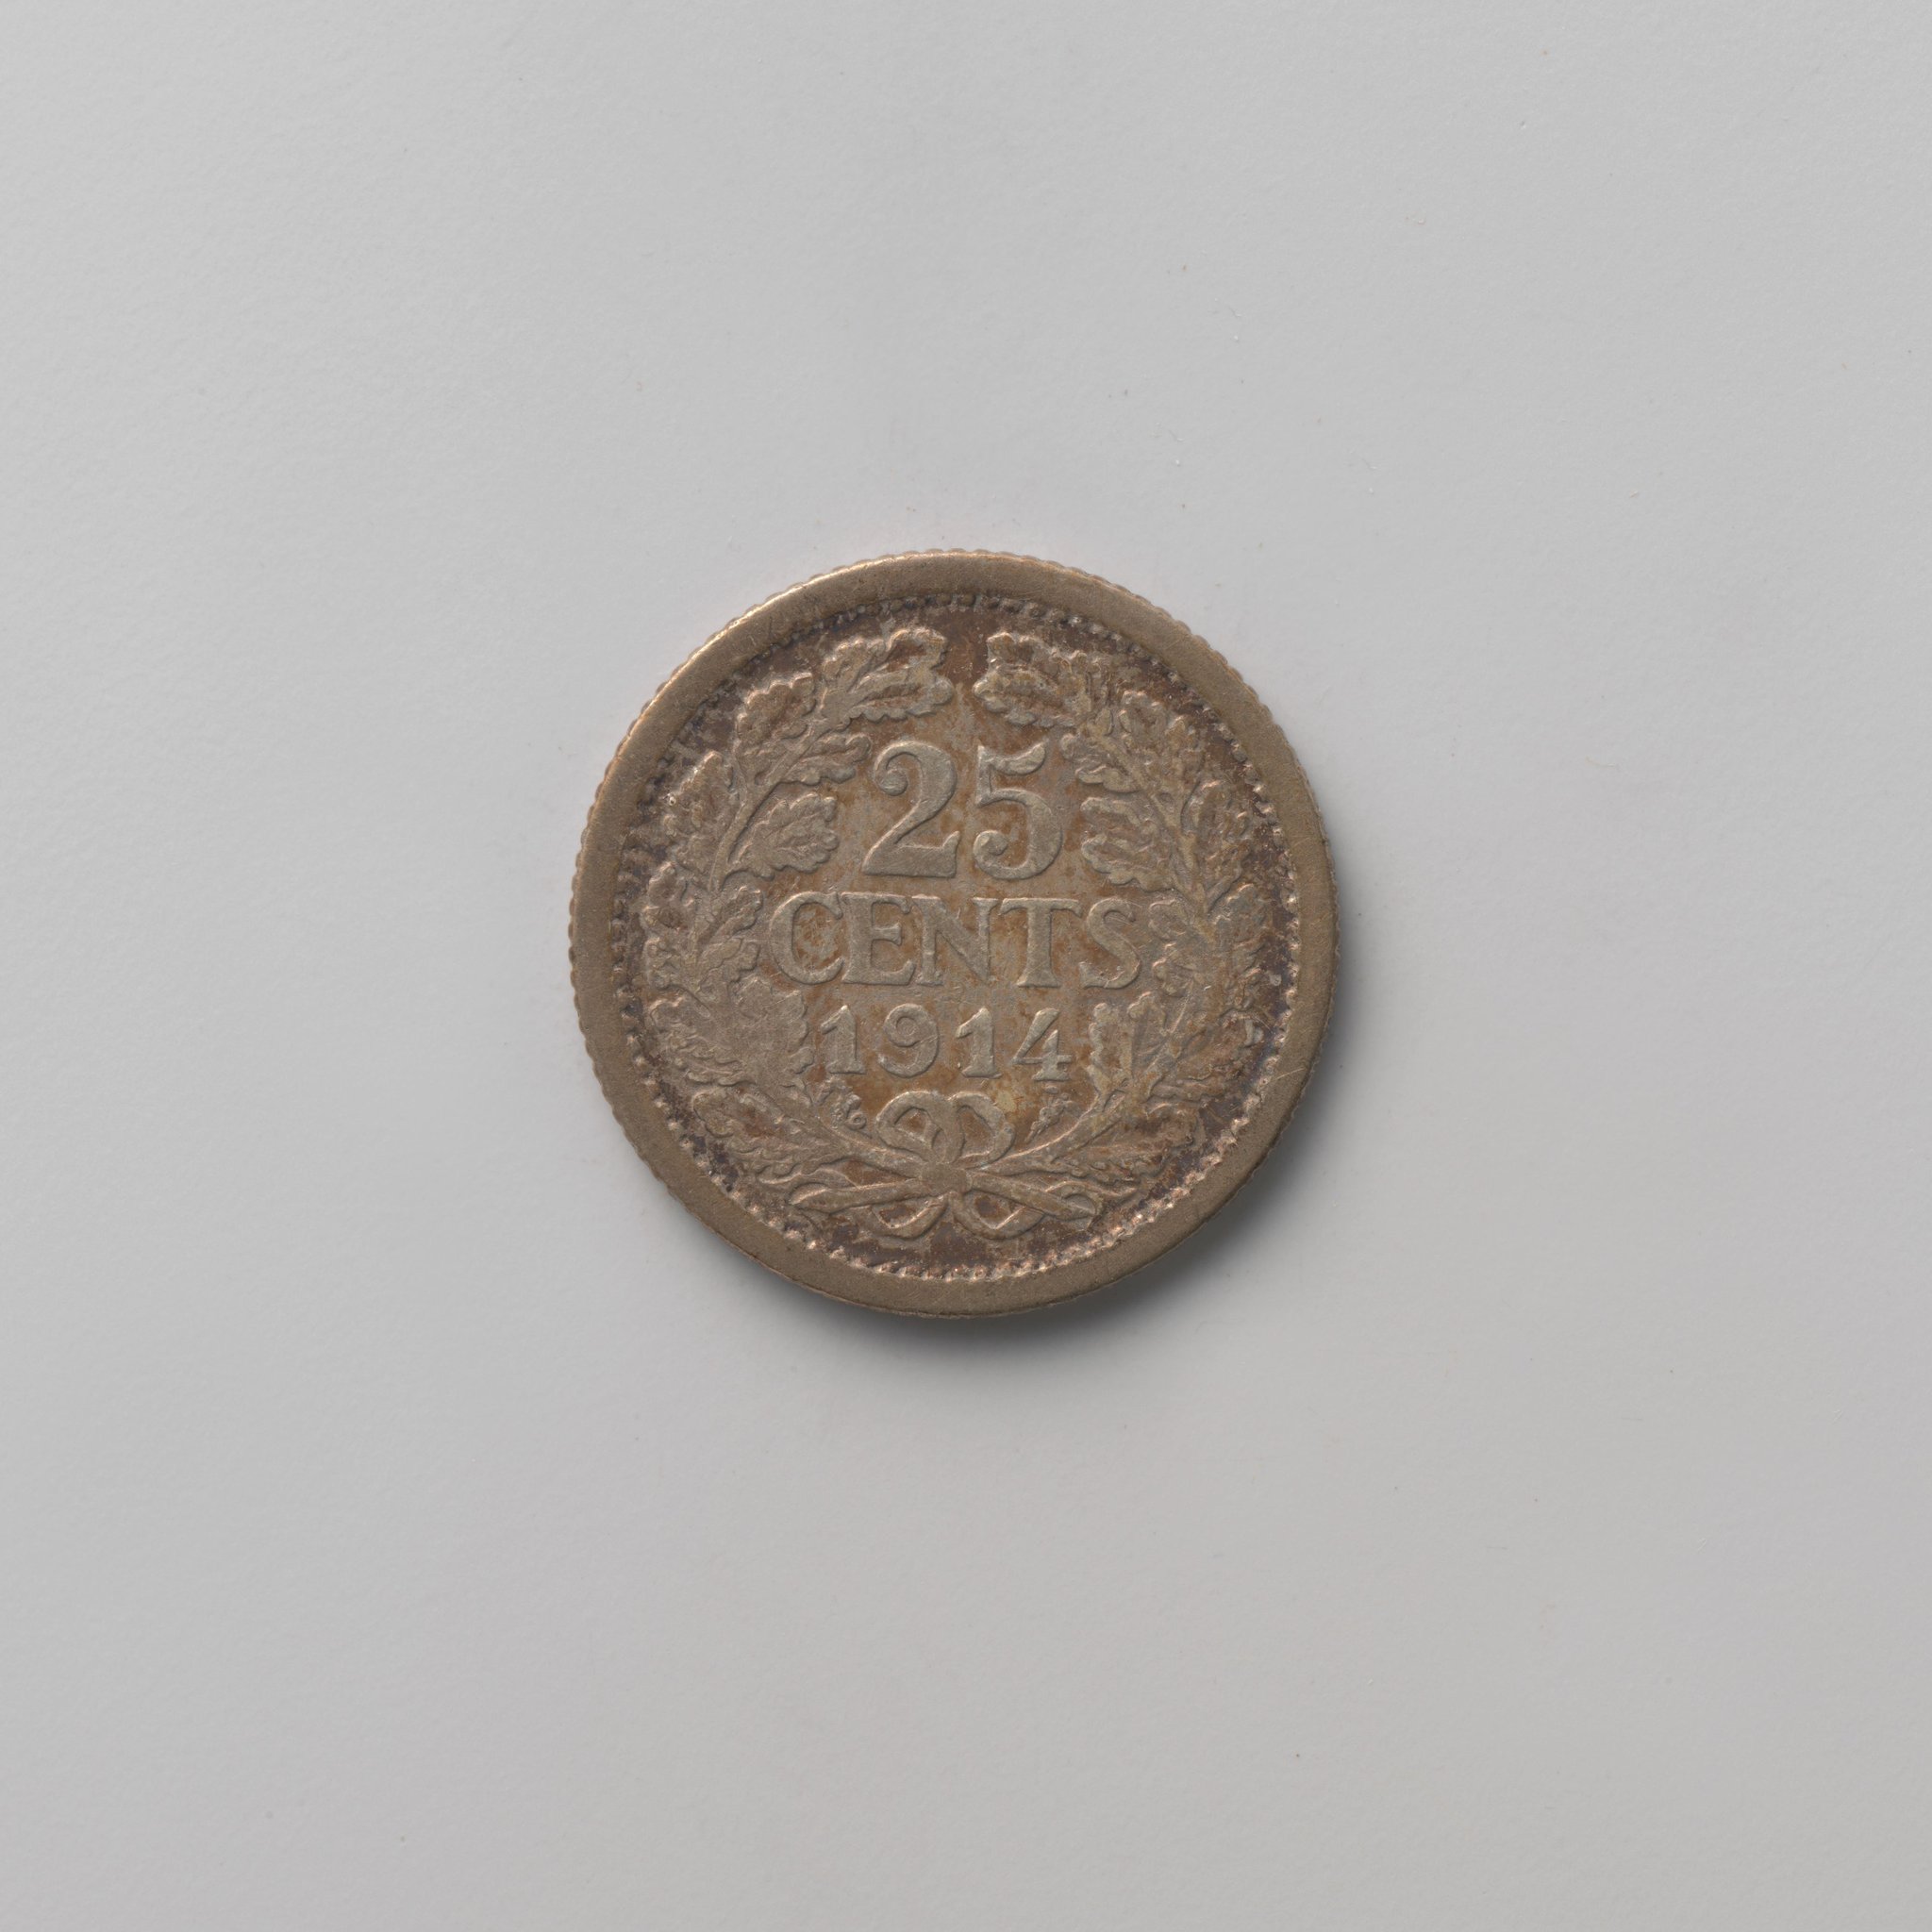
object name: coin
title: Nederland, 25 cent,1914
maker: wilhelmina of the netherlands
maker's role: print maker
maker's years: 1880-1962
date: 1914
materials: silver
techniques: striking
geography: utrecht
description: Zilveren munt. Voorzijde: gedrapeerd borstbeeld naar links. Keerzijde: binnen twee samengebonden eiketakken waarde-aanduiding 25 cents en jaartal. Kartelrand.